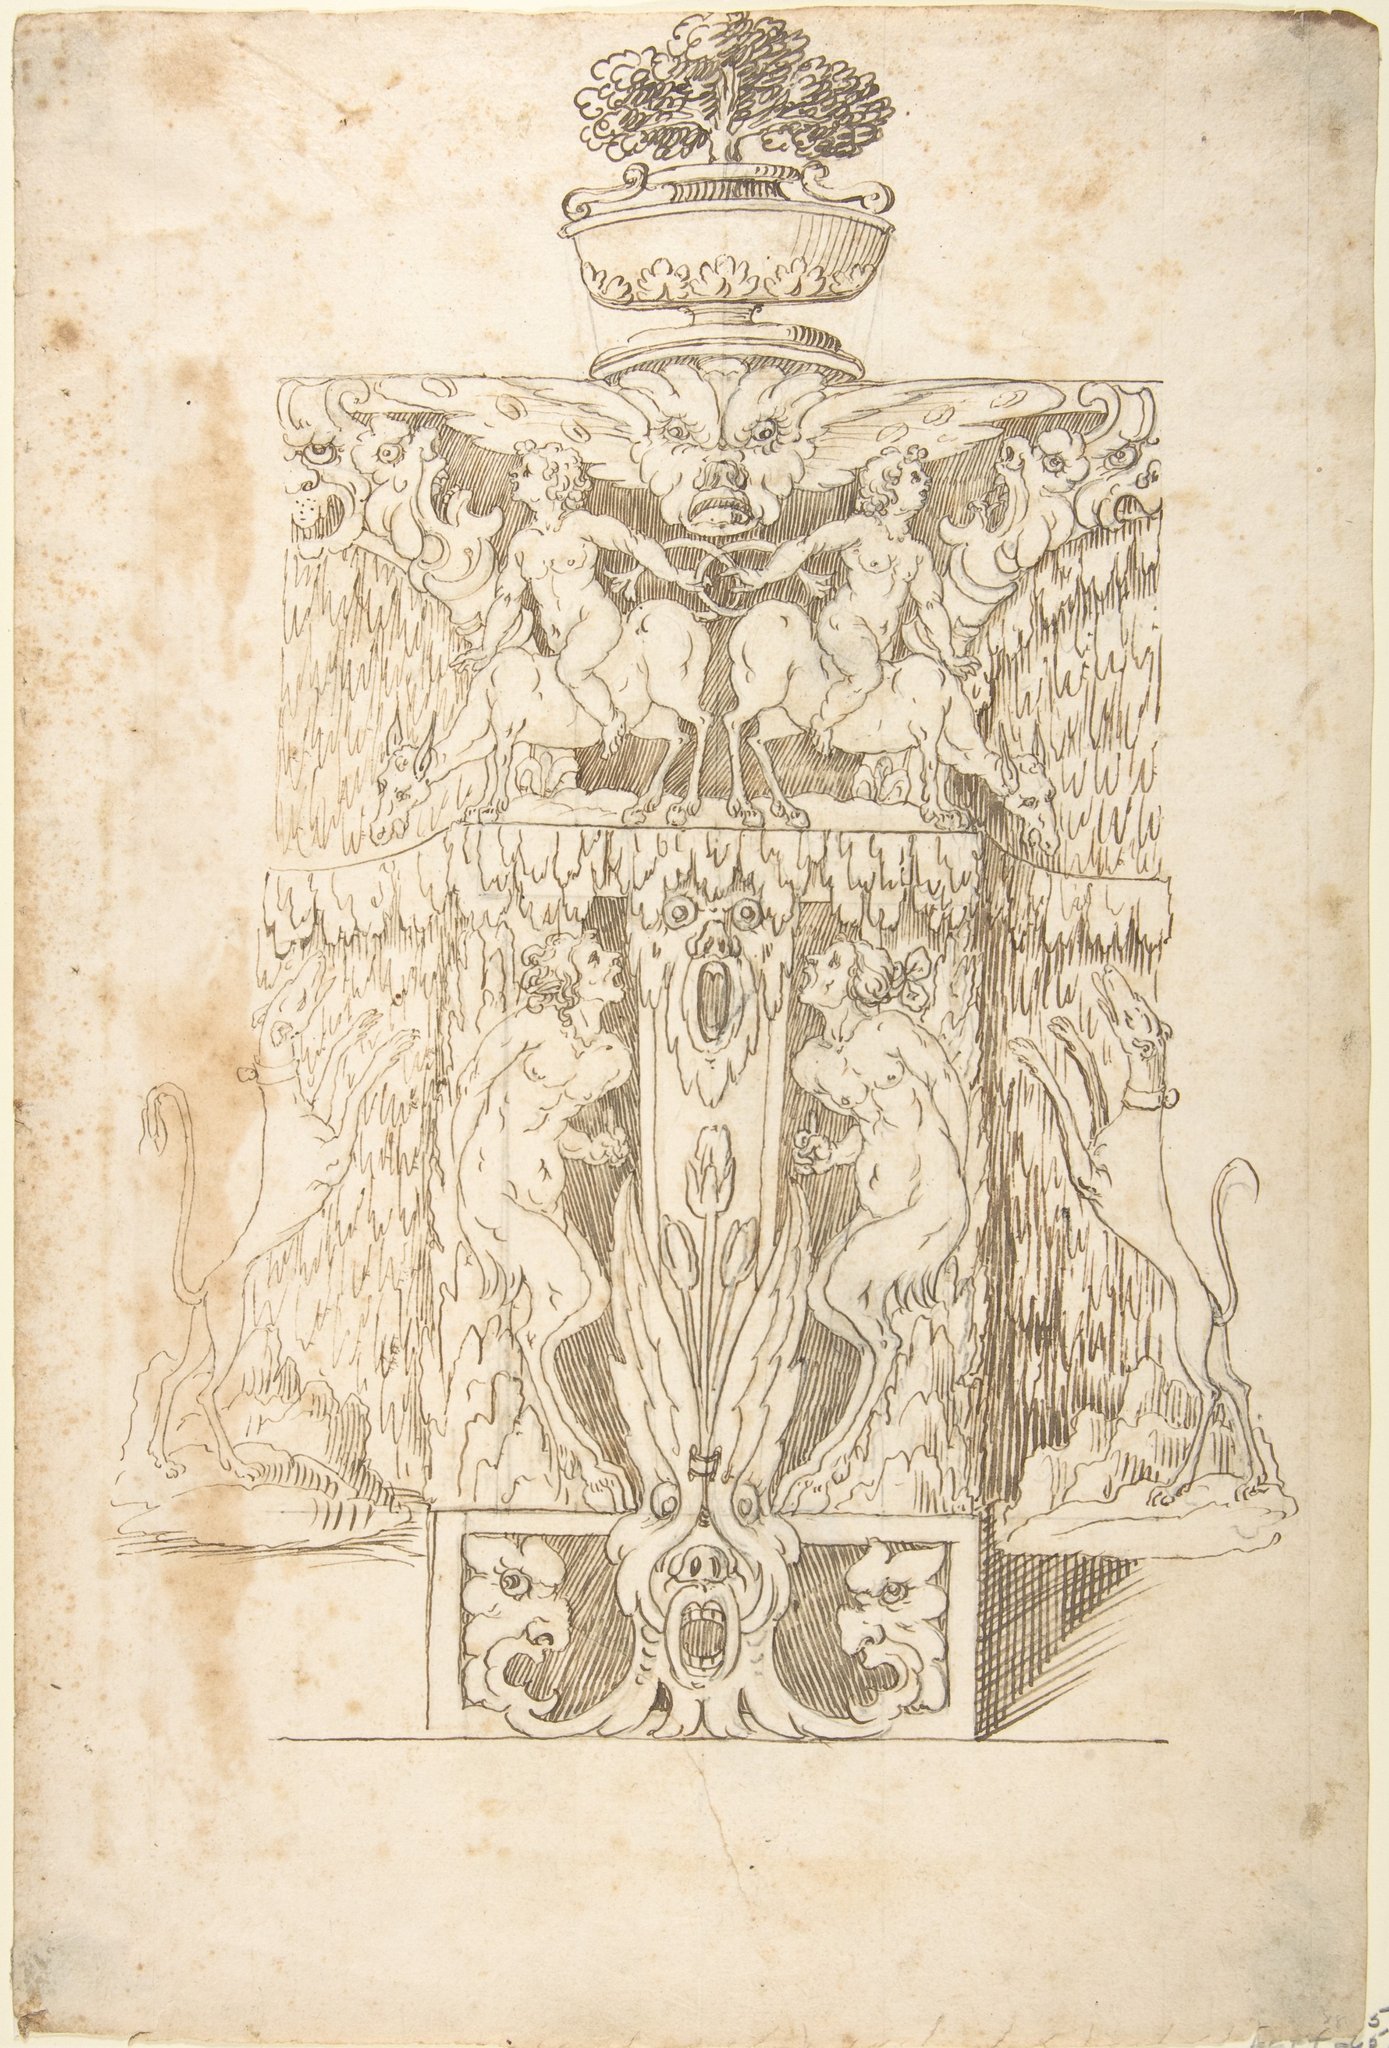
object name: drawing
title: Design for a Wall Fountain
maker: anonymous, italian, lombard, 16th century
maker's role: artist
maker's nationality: italian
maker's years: 1500-1600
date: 1550-1620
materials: graphite, ink, drawing material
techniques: pen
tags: fountains,dogs,horses